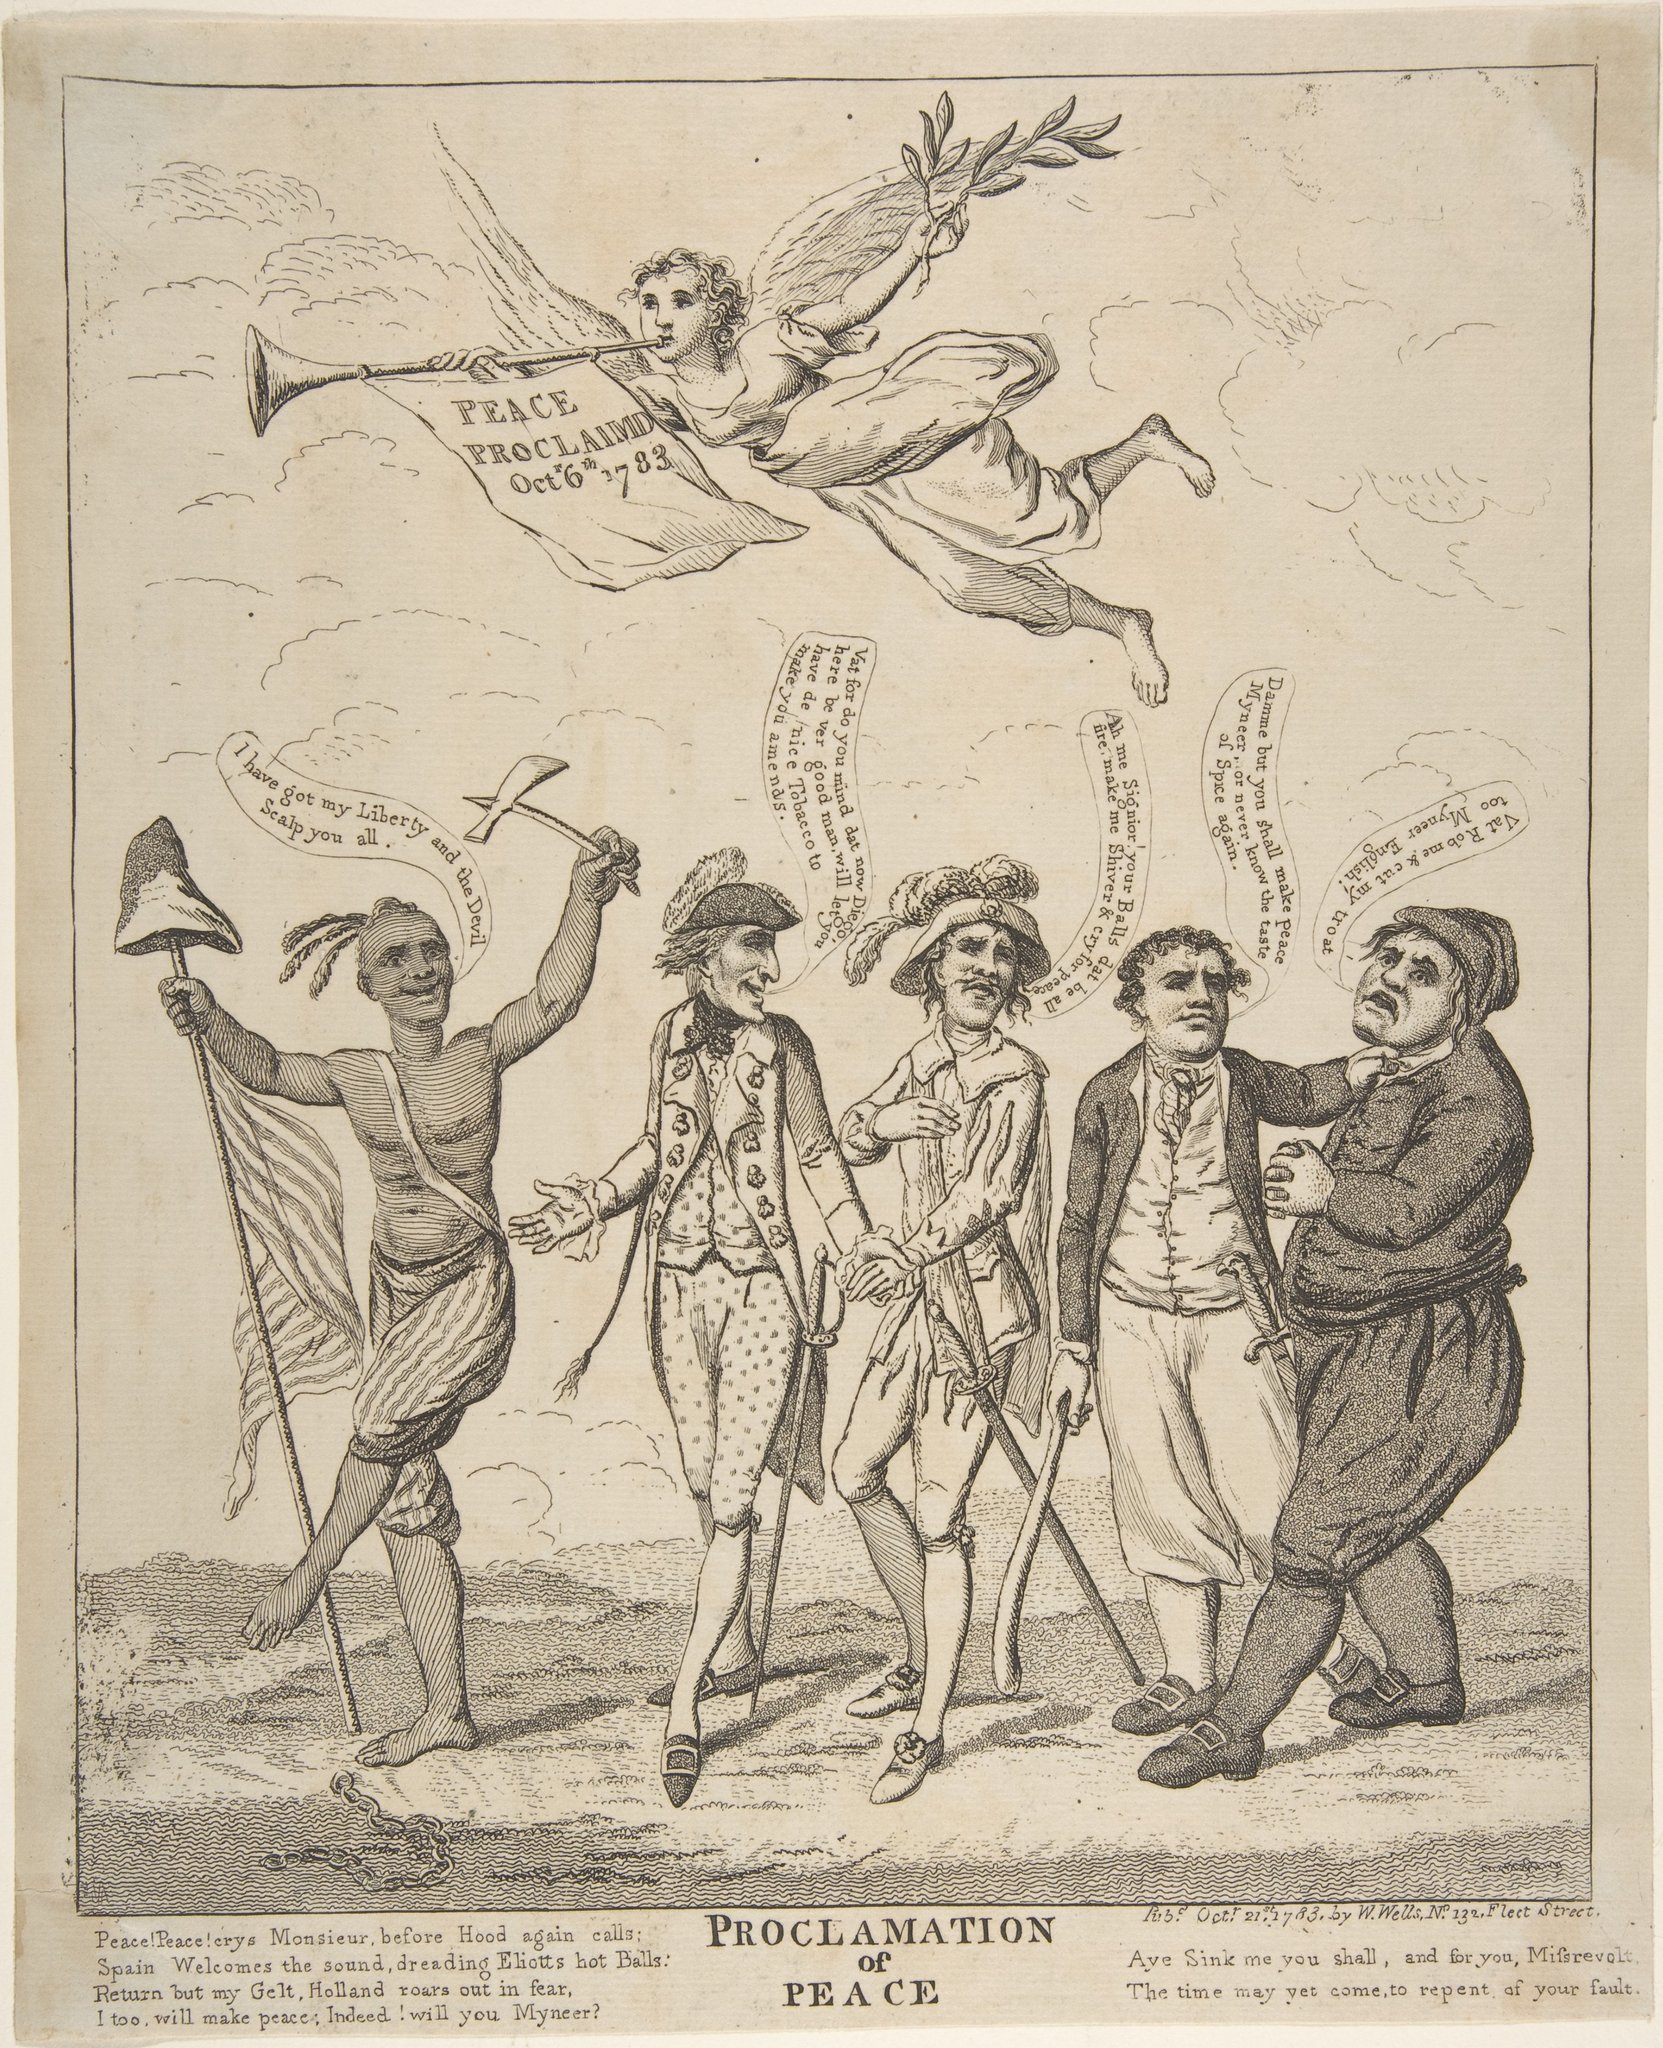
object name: print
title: Proclamation of Peace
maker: anonymous, british, 18th century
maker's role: artist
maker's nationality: british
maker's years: 1700-1800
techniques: etching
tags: satire,american revolution,men,politics